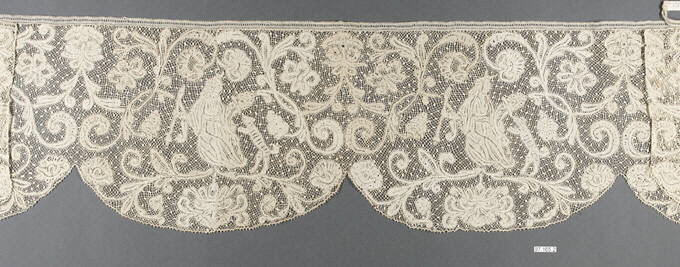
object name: fragment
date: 1601-1700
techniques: lace